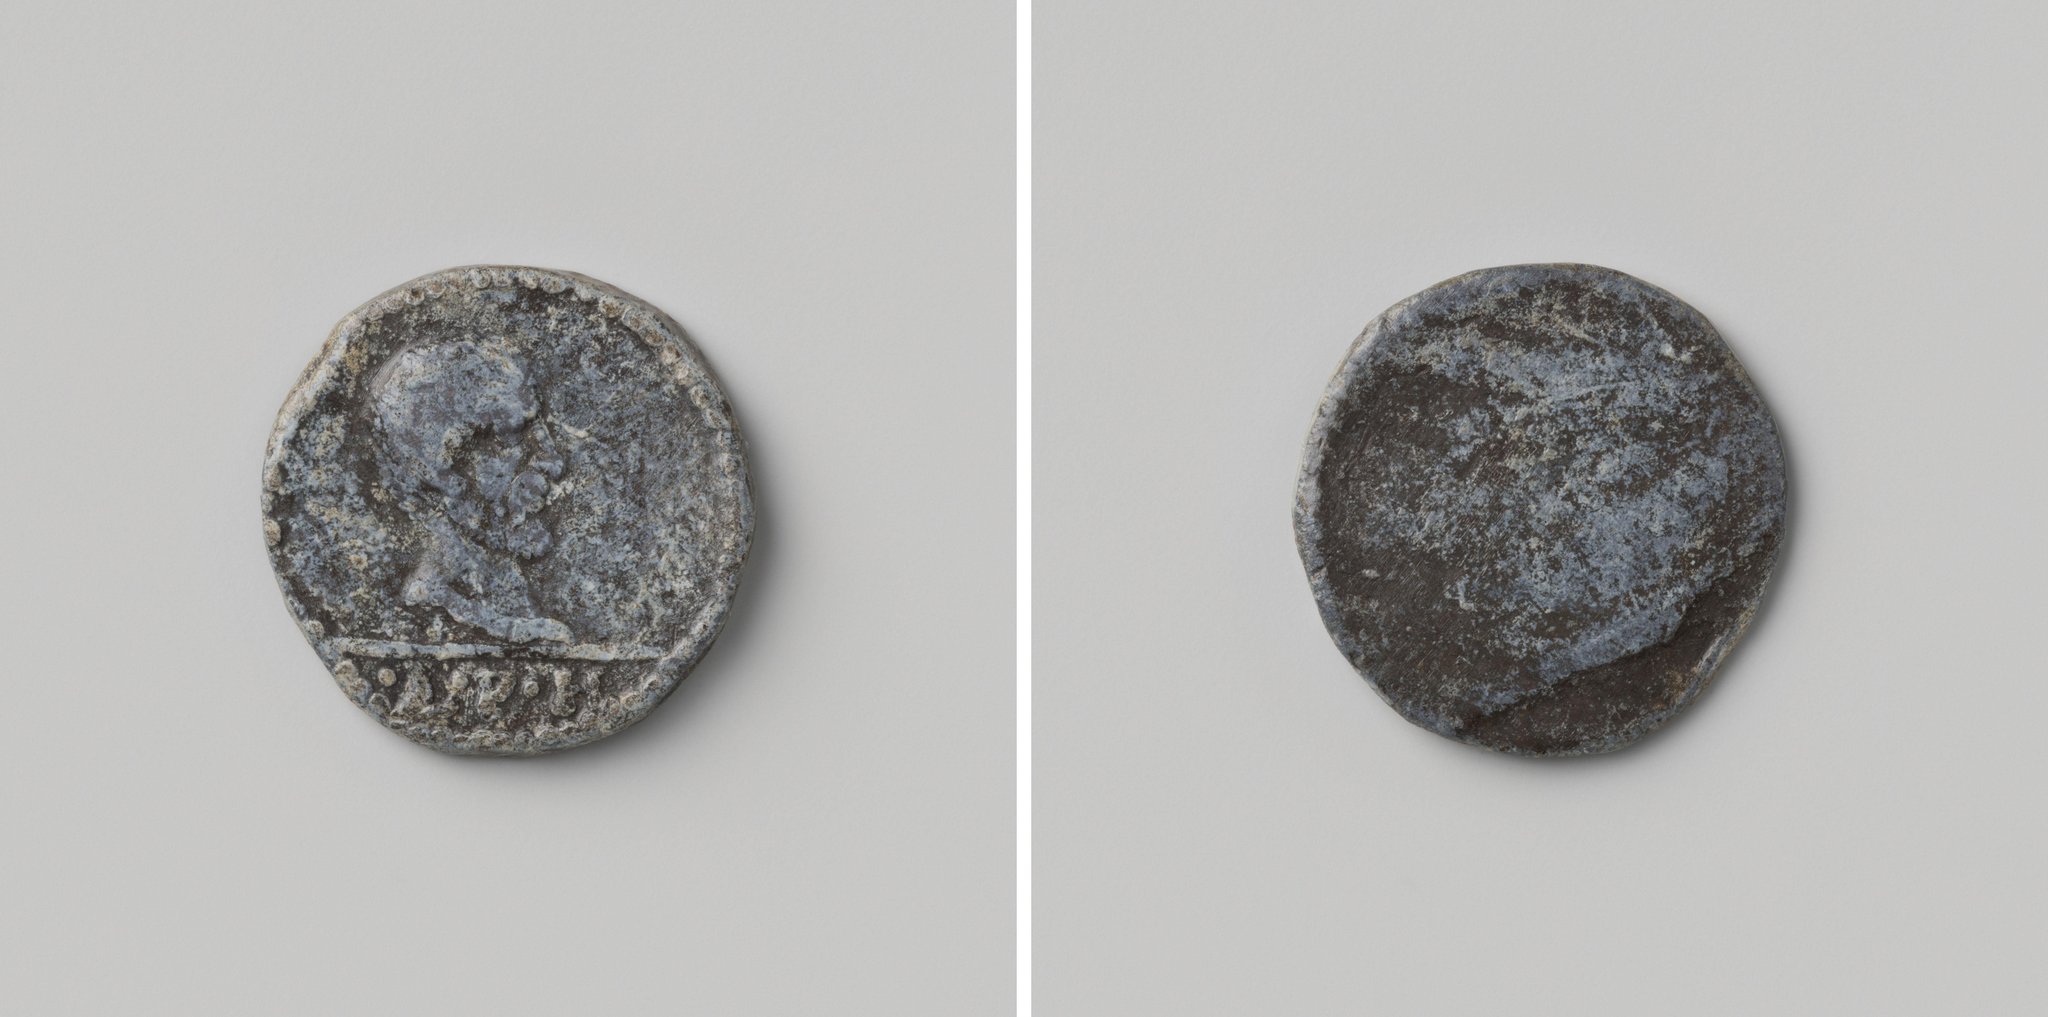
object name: medal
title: Penning van lood van het Leprooshuis in Enkhuizen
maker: Anonymous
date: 1600-1850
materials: lead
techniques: striking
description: Enkelzijdige loden penning van het Leprooshuis in Enkhuizen. Voorzijde: borststuk man naar rechts; afsnede: monogram van letters LPH binnen parelrand. Keerzijde: blanco.